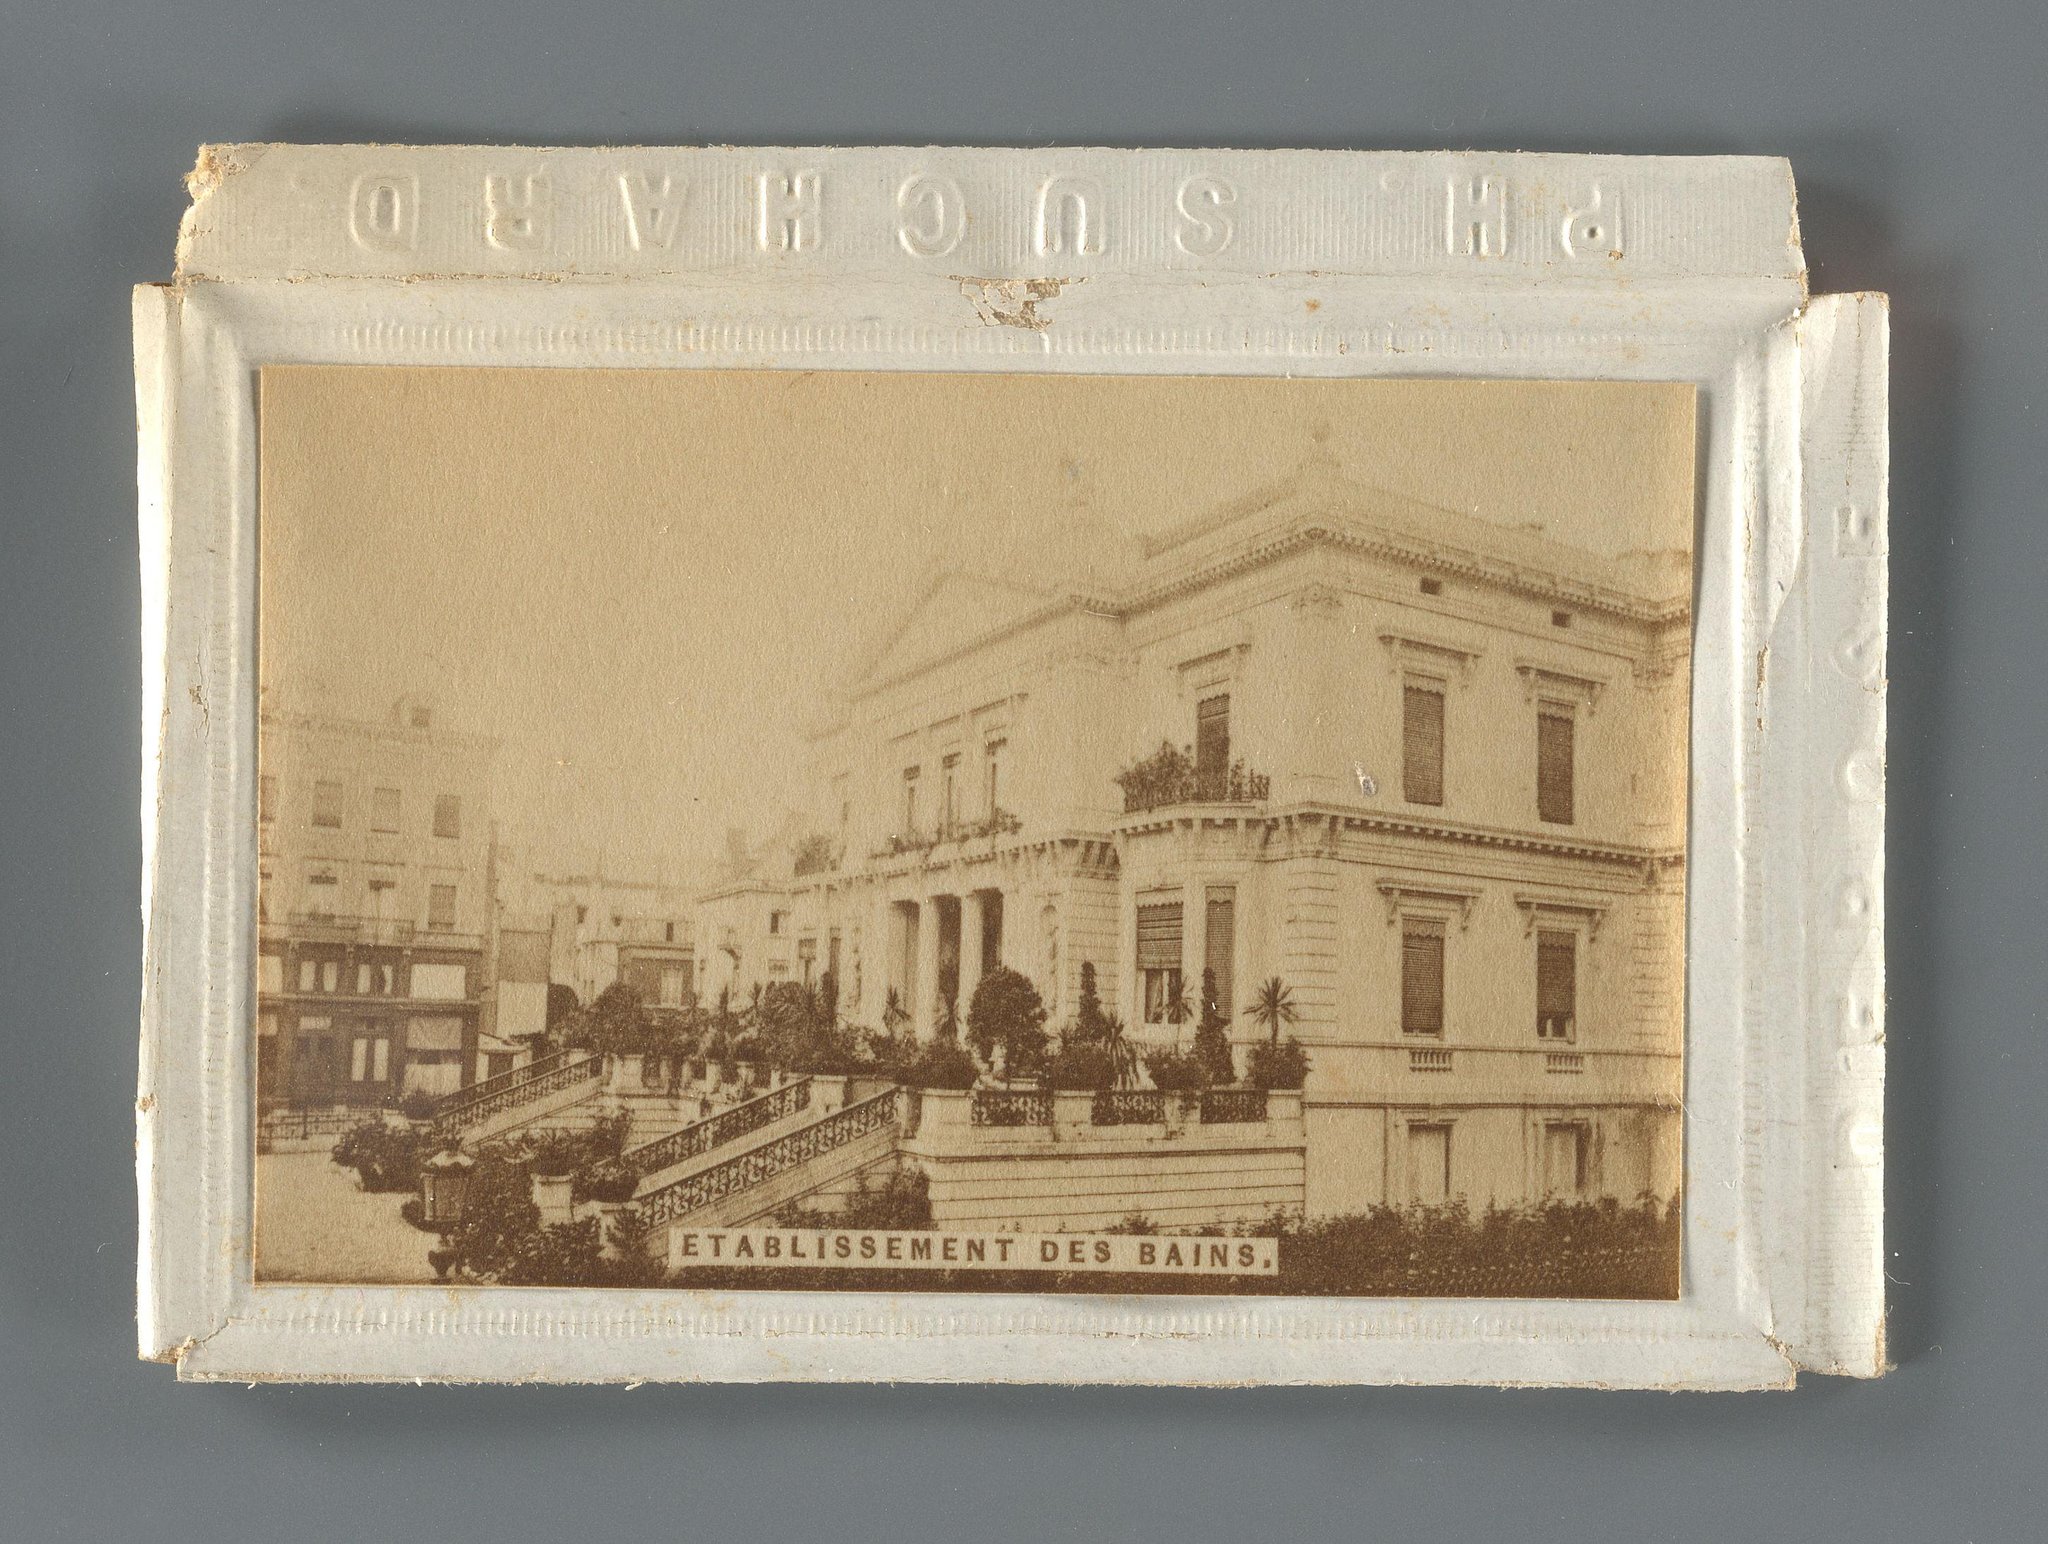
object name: photograph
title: Établissement des bains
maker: Anonymous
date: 1880-1890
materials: cardboard, paper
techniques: albumen print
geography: spa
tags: public baths